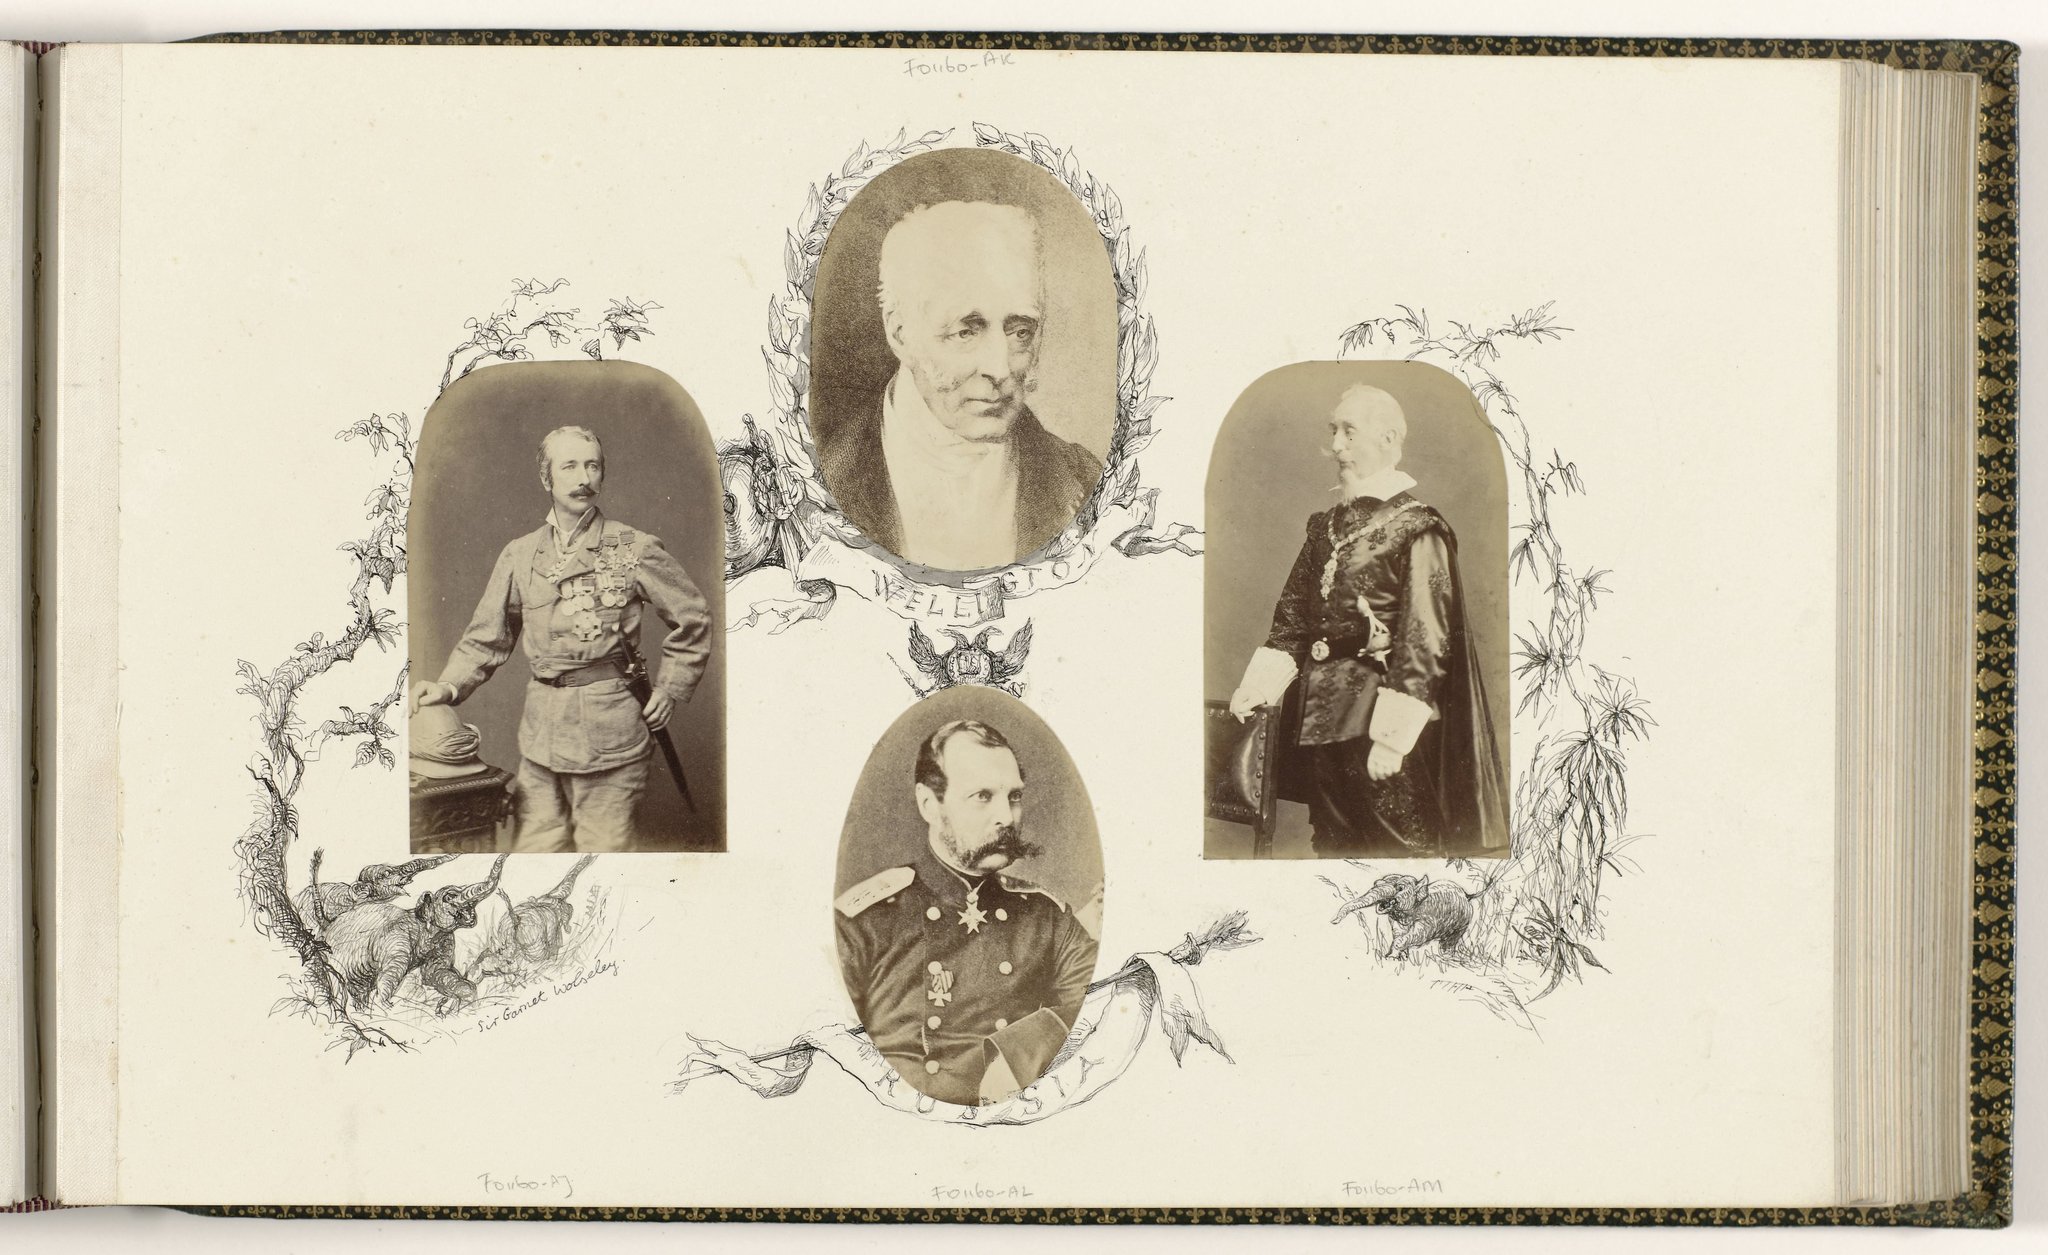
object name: album leaf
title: Portret van Garnet Wolsleley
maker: Anonymous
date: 1865-1875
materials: paper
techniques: albumen print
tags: commander-in-chief, general, marshal, historical persons